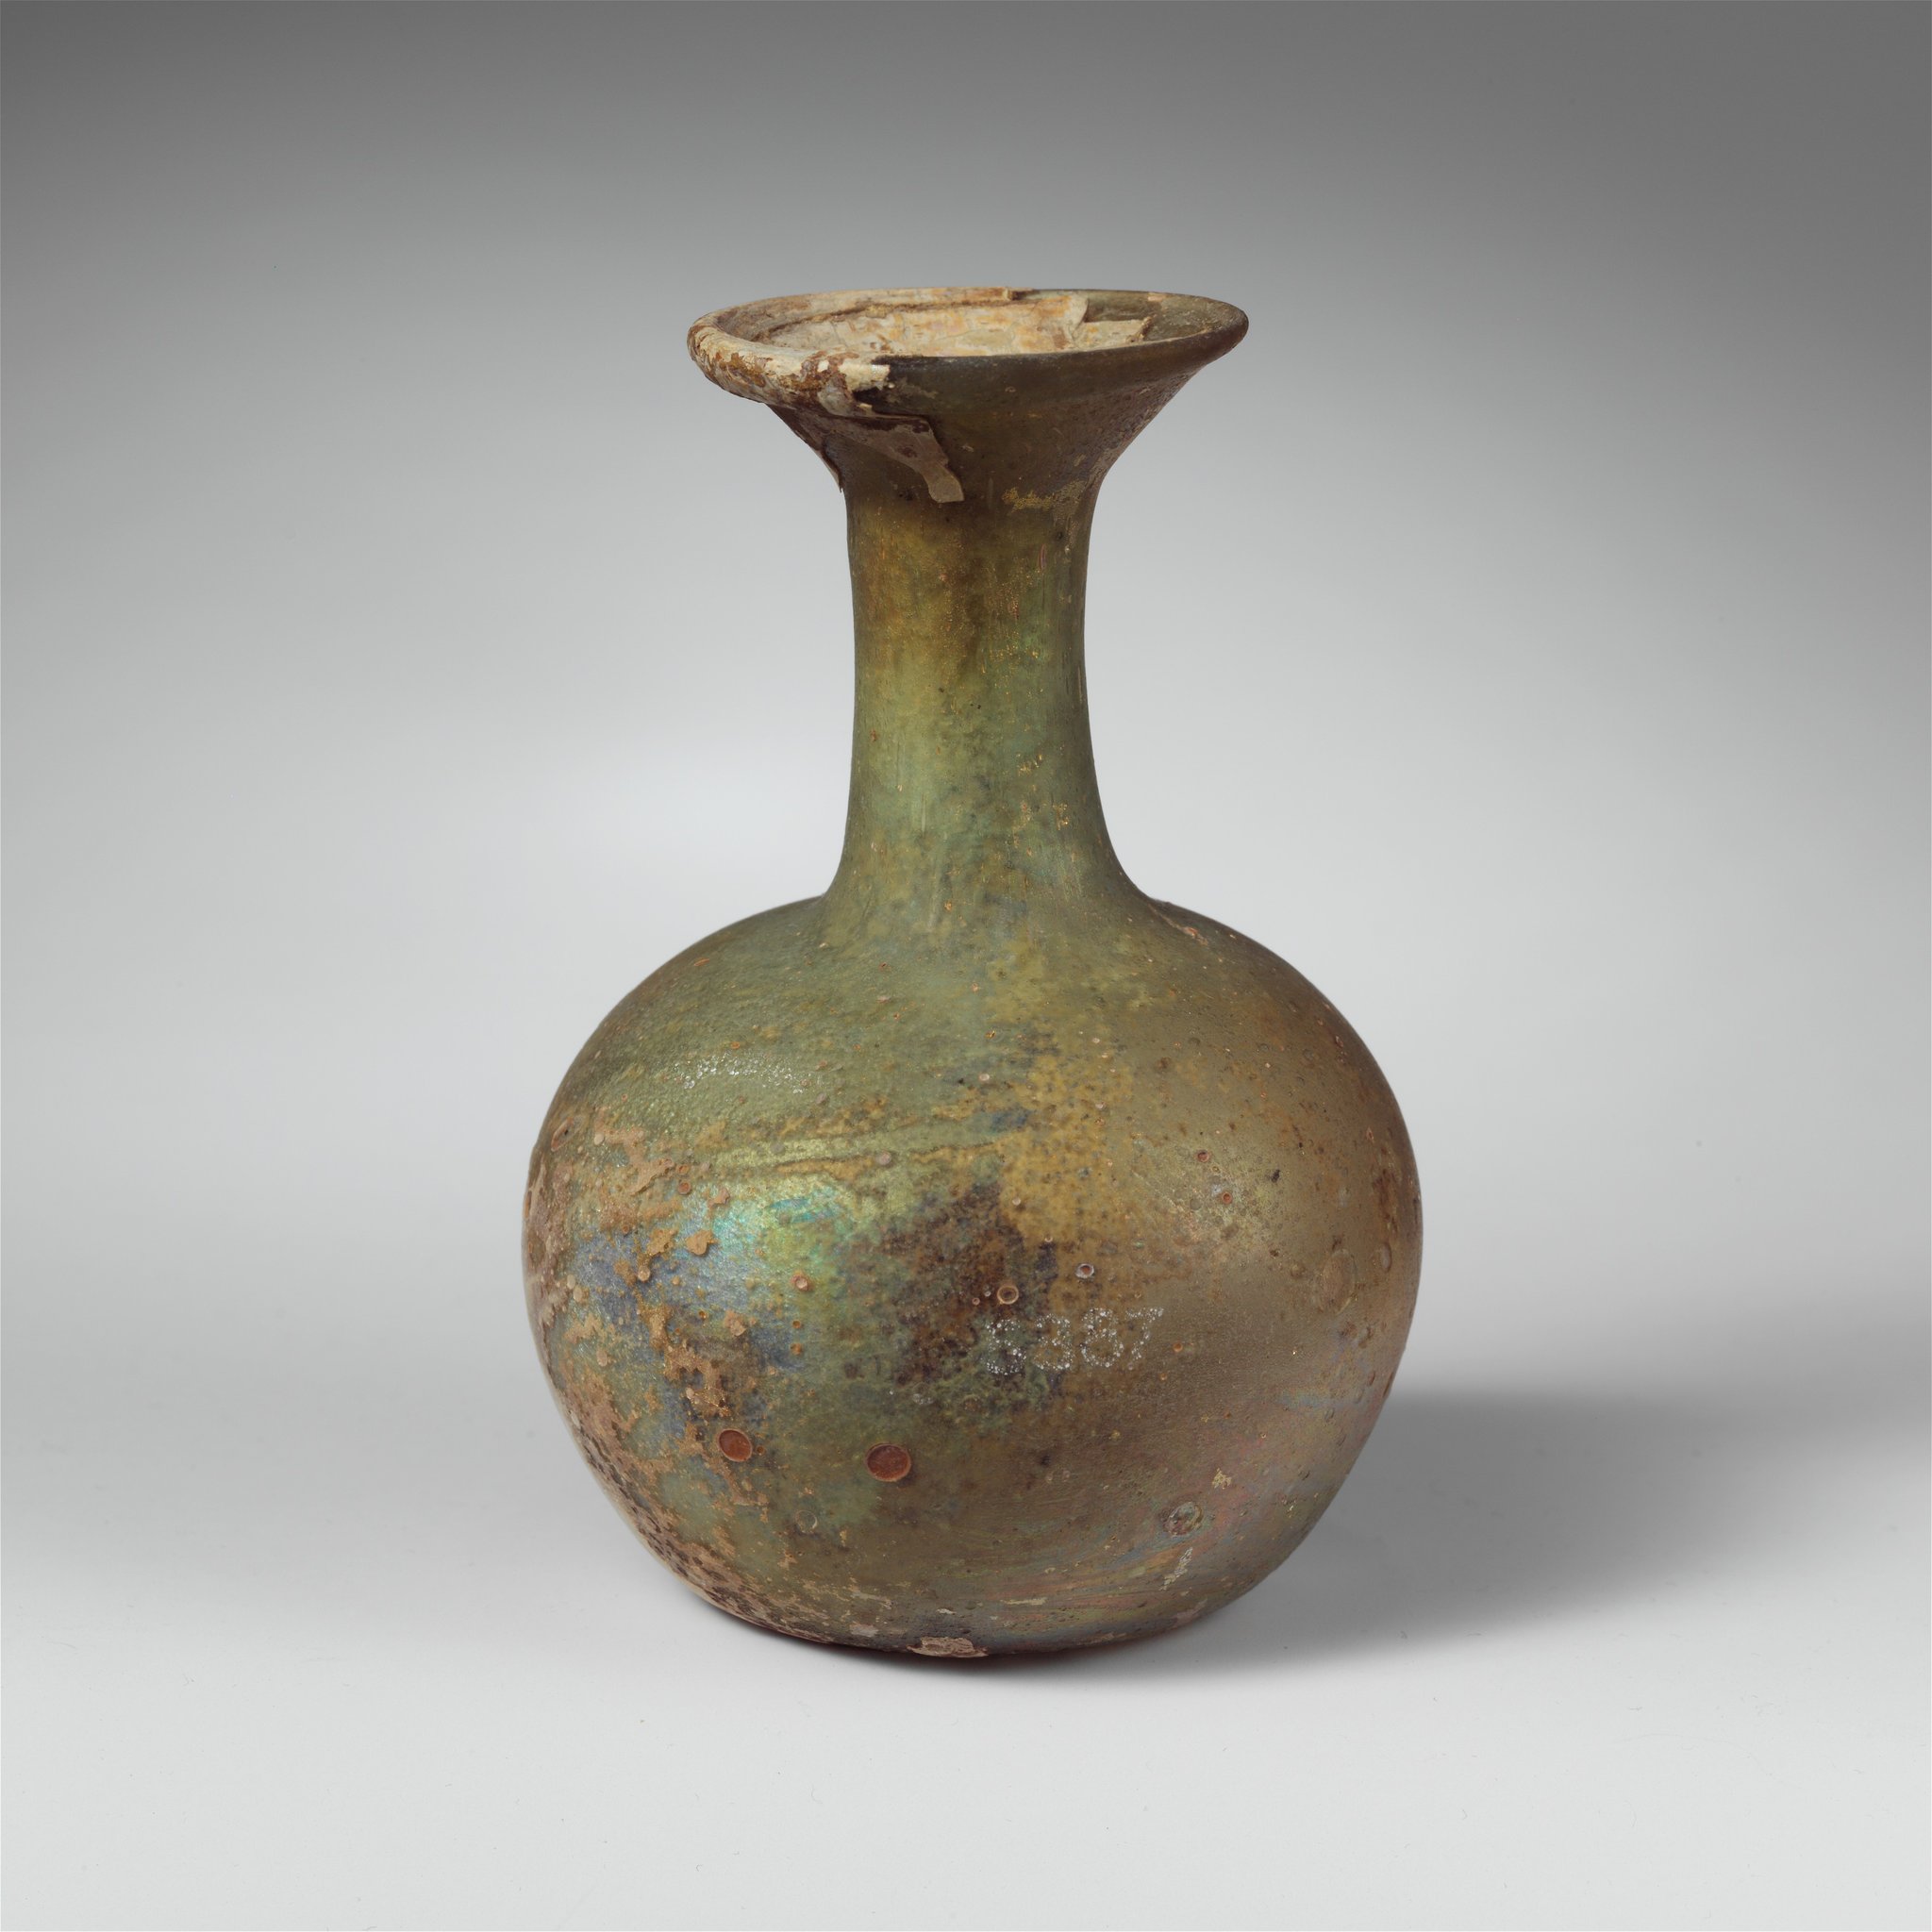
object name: bottle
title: Glass flask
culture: roman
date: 101-300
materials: glass